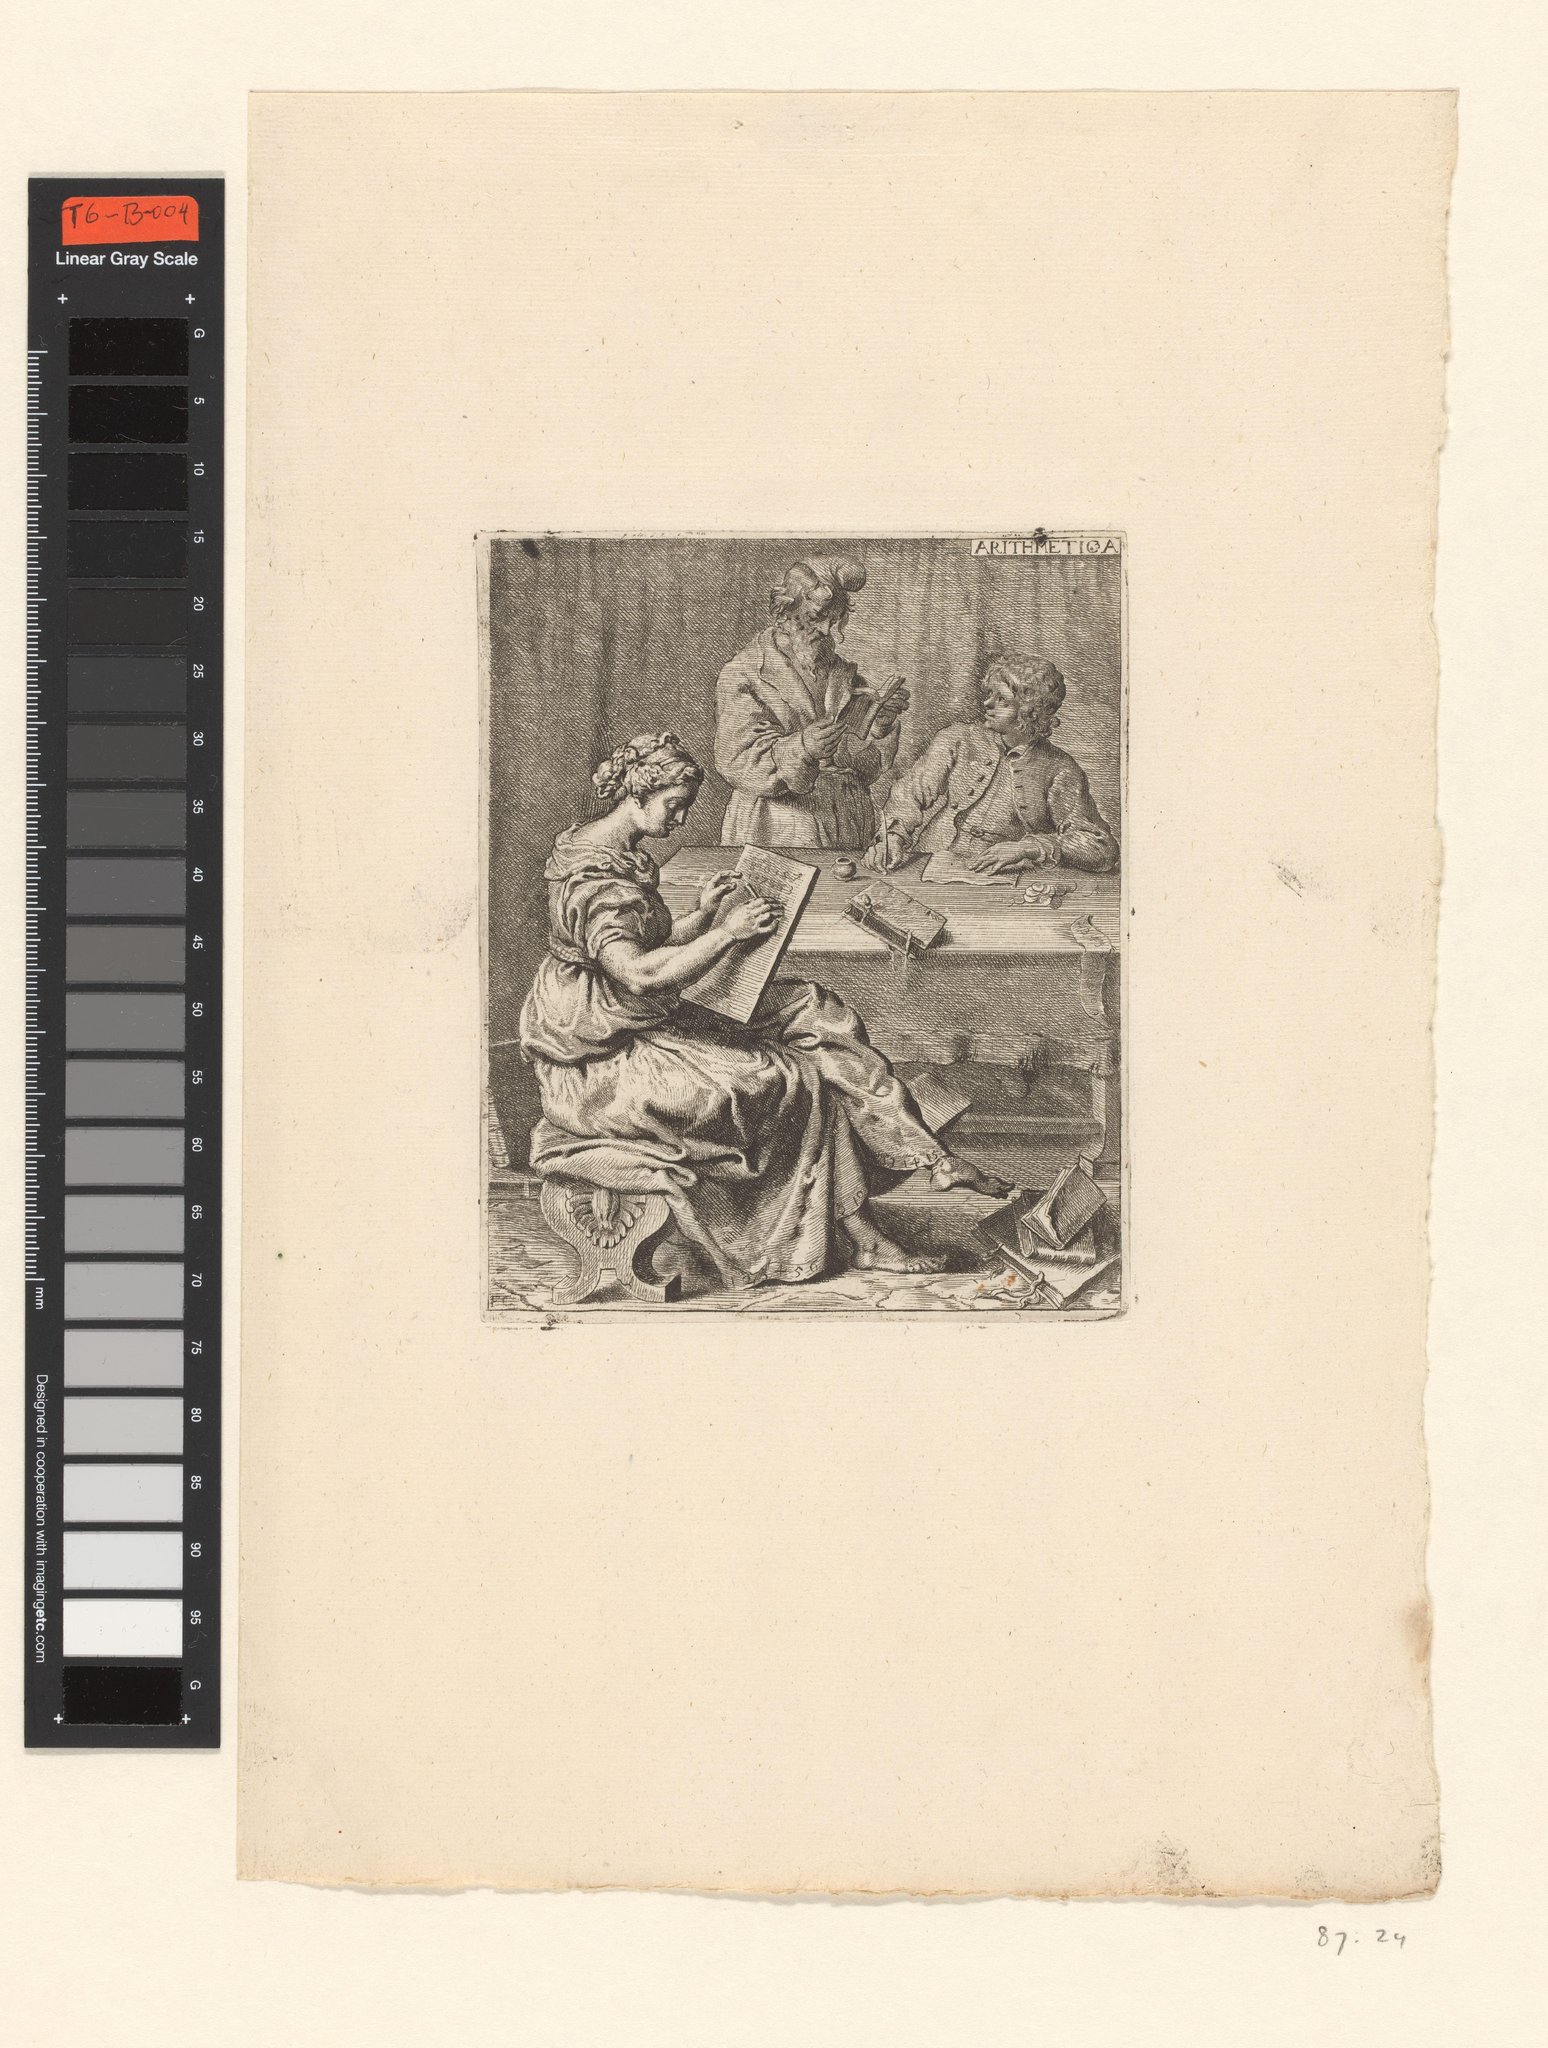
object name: print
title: Arithmetica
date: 1645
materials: paper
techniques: etching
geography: london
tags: education, science and learning, the liberal arts, 'artes liberales', 'arithmetica' (~ quadrivium); 'aritmetica' (ripa), book, book-keeping, accountant, numerals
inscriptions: collector's mark: Lugt 2228, collector's mark: Lugt 2760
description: Onderdeel van een serie van zeven prenten en een titelprent.